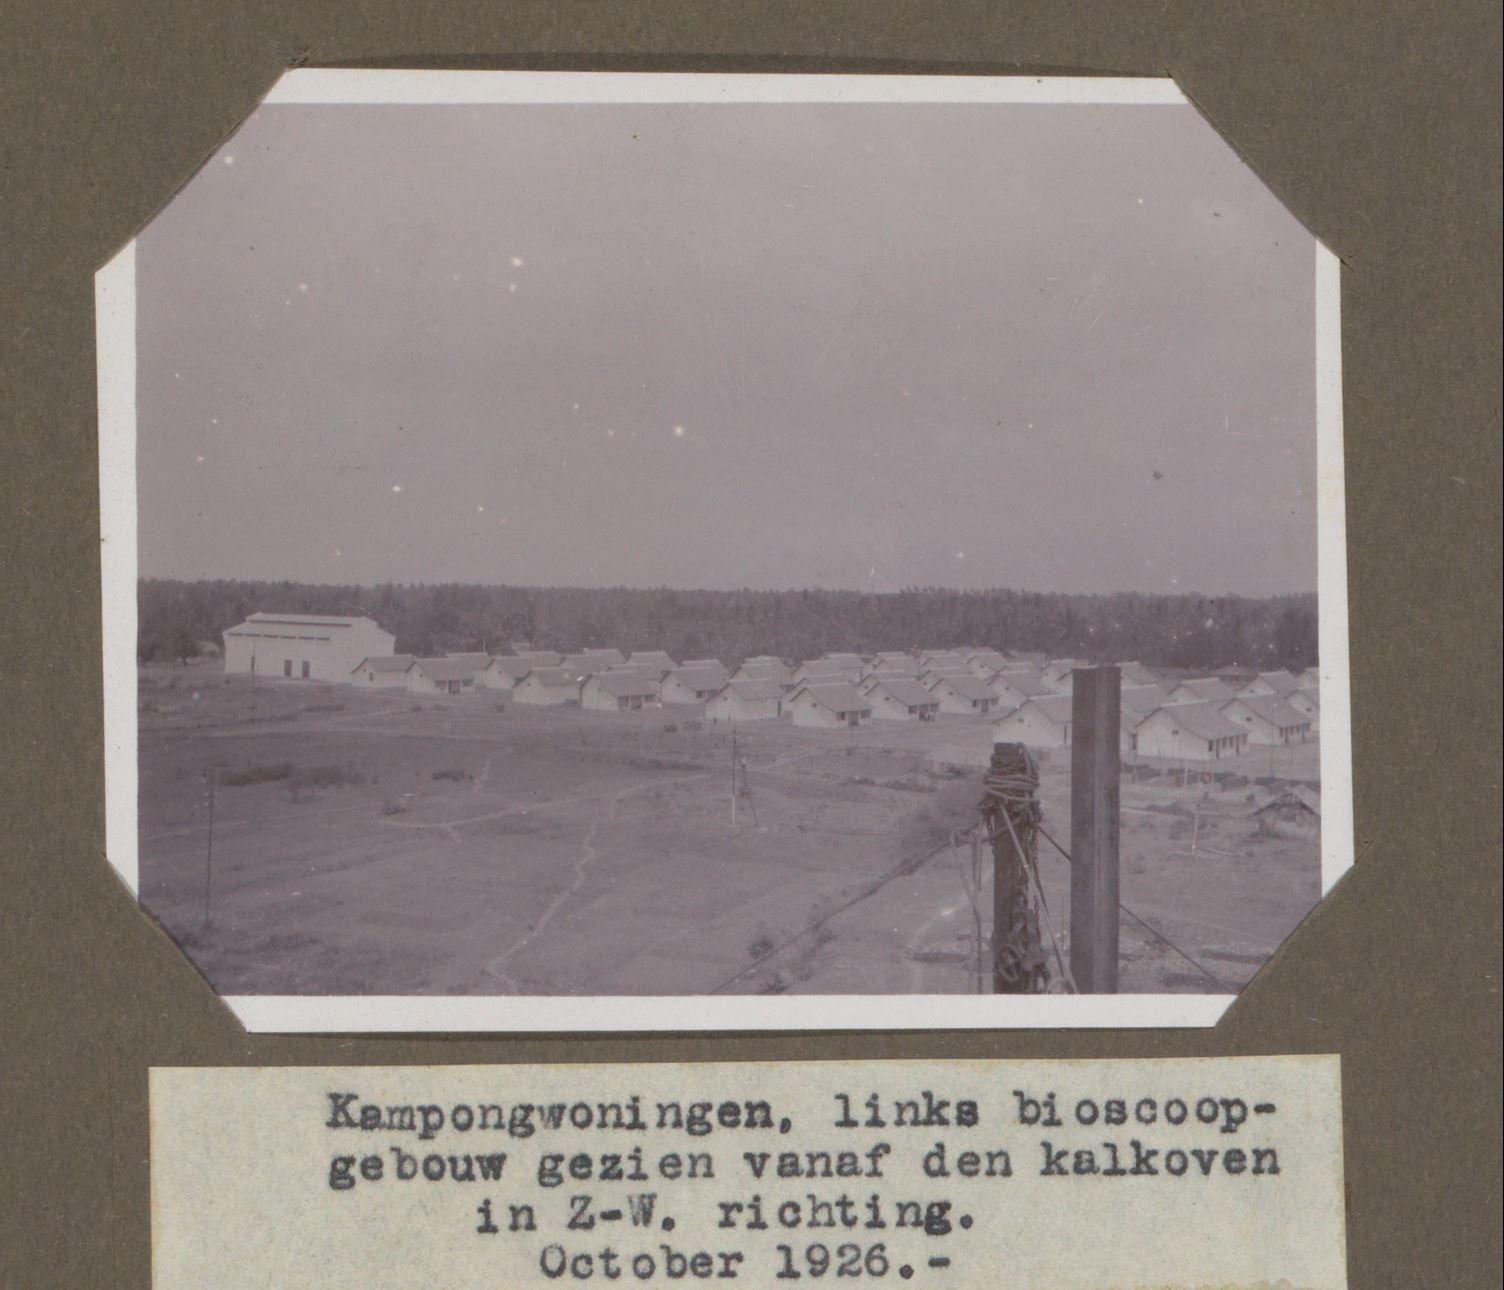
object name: photograph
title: Kampongwoningen, links bioscoopgebouw gezien vanaf den kalkoven in Z-W. richting. October 1926.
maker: Anonymous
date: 1910-1926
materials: photographic support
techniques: gelatin silver print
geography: east java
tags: colonial system, trade-company, making the overground structures (~ building activities), (non-fruit) products of plants or trees: sugarcane, representation of real building (either existing or having existed)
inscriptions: inscription: ‘Kampongwoningen, links bioscoopgebouw gezien vanaf den kalkoven in Z-W. richting. October 1926.’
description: Gezicht op de kampongwoningen en de bioscoop op het fabrieksterrein, oktober 1926. Onderdeel van het fotoalbum met foto's van de opbouw van de suikerfabriek te Goenoengsari op Oost-Java door de Handels Vereniging Amsterdam 1926-1927.